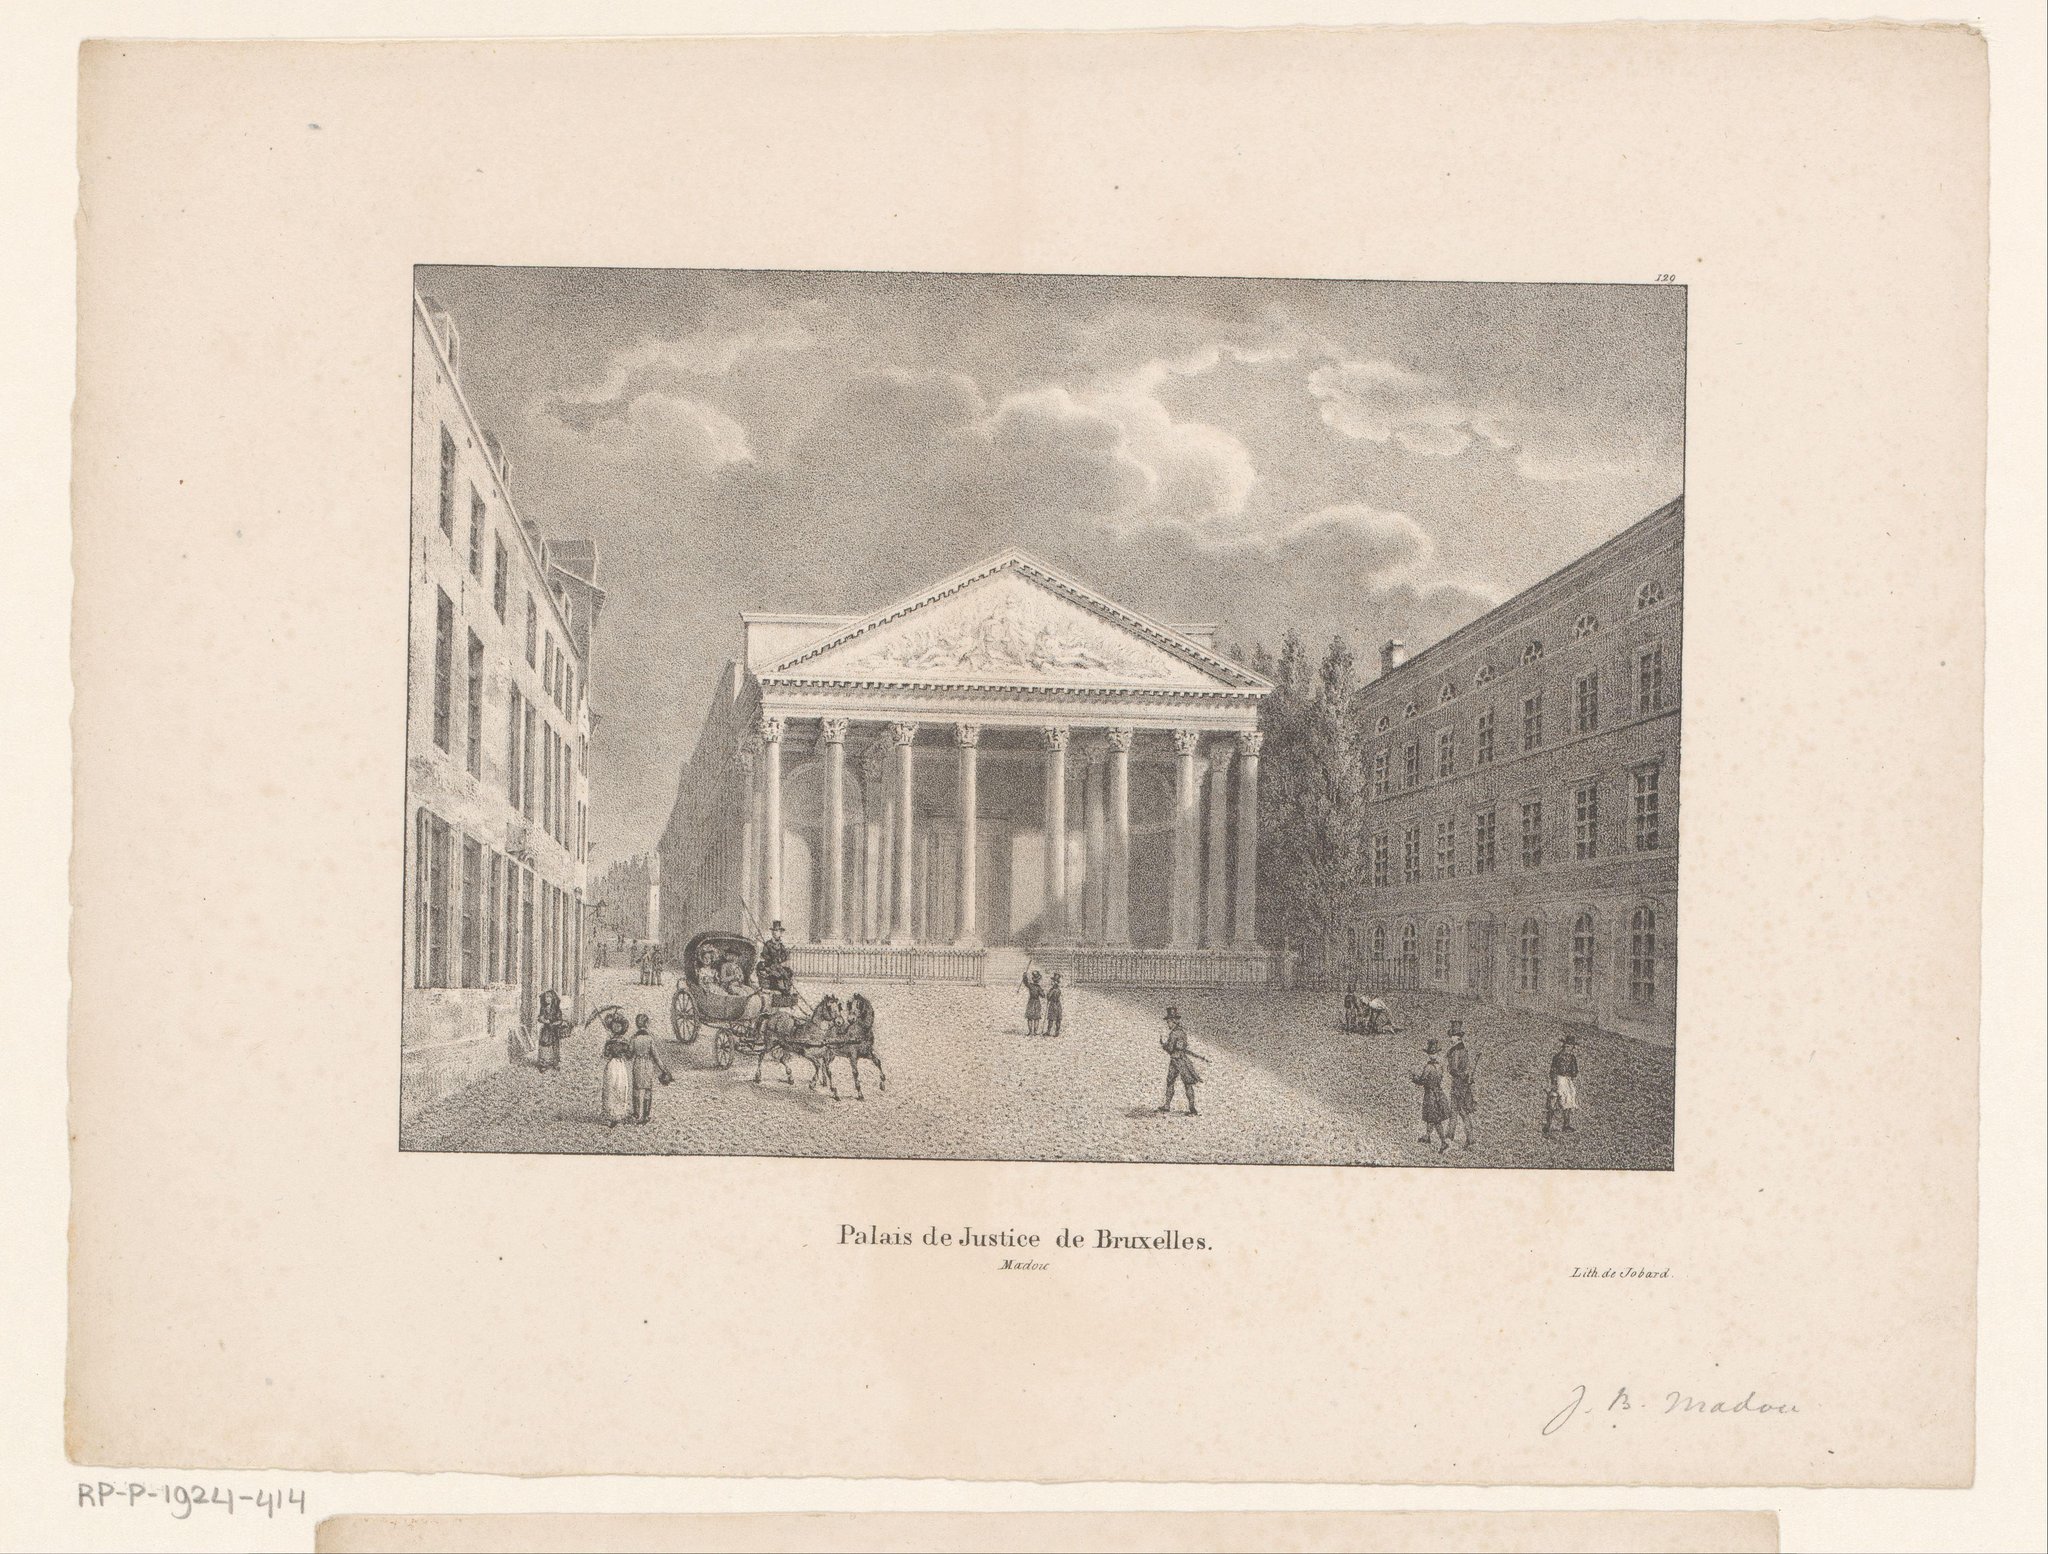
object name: book illustration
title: Gezicht op het oude paleis van justitie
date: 1825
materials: paper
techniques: lithograph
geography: brussels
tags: square, place, circus, etc., court building, brussels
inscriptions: collector's mark: Lugt 2233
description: Prent gebruikt in: Cloet, J.J. de. Voyage pittoresque dans le royaume des Pays Bas (...). Brussel: Jean Baptist Ambroise Marcellin Jobard, 1825. Afleveringen voor deze publicatie verschijnen vanaf 1822. In 1825 zijn er onder deze titel twee banden vervaardigd. Wegens succes krijgt de publicatie een vervolg onder de titel 'Châteaux et monumens des Pays-Bas faisant suite au voyage pittoresque'.